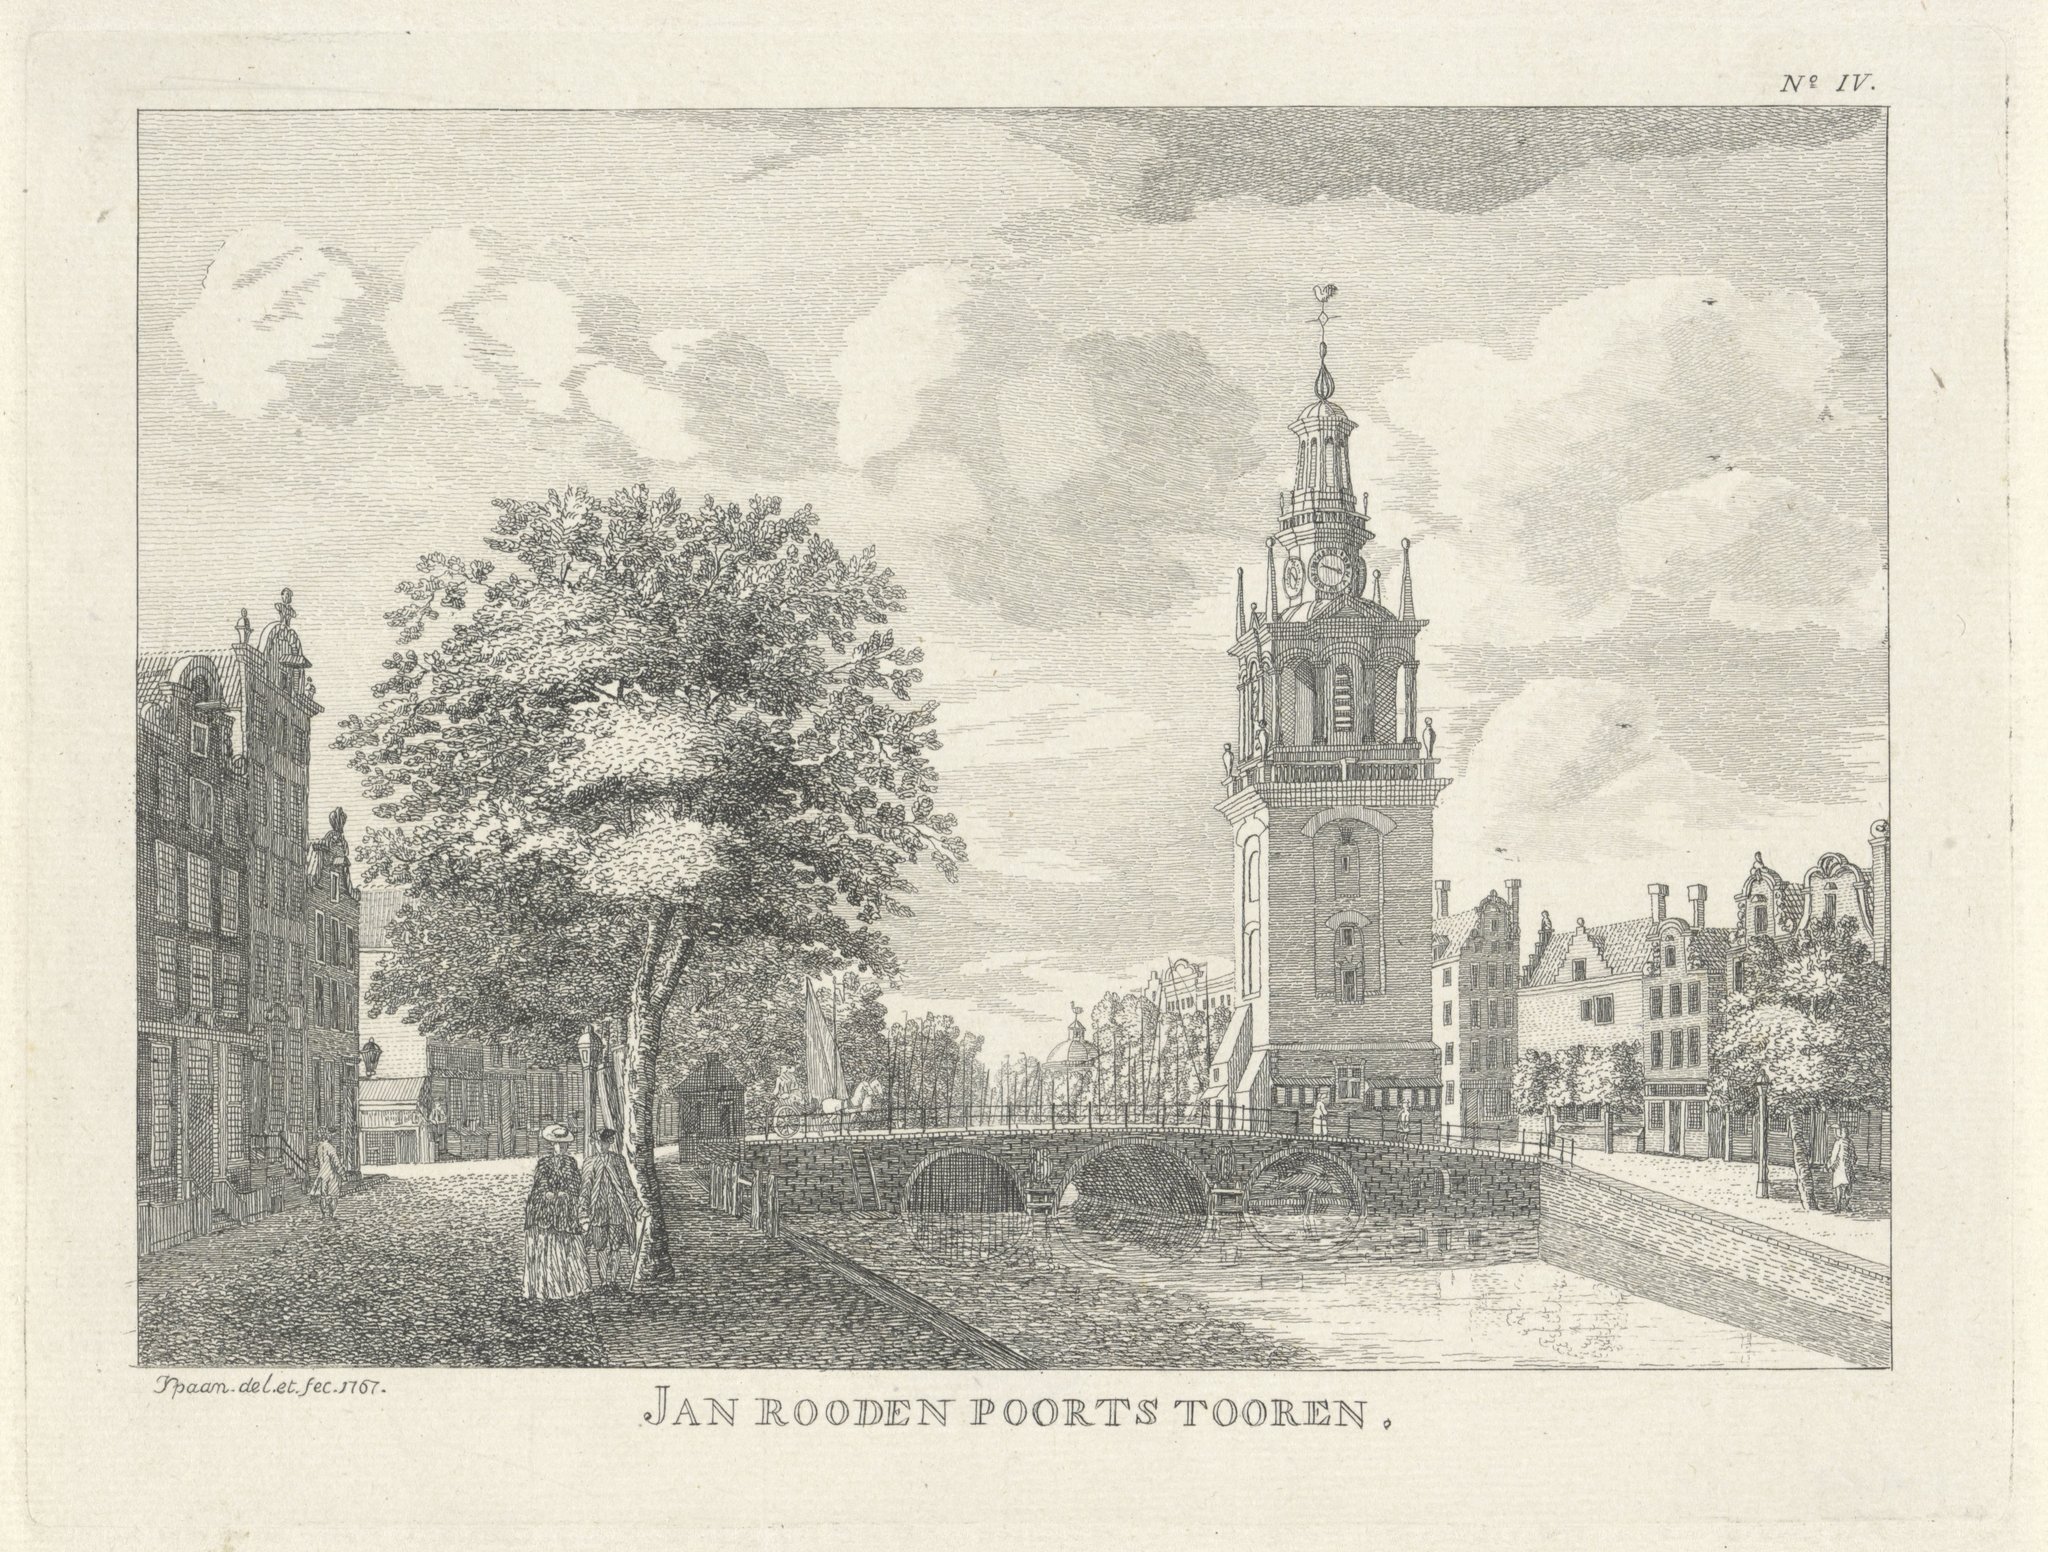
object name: print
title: Jan Rooden Poorts Tooren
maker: jan spaan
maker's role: print maker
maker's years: 1742-1828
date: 1767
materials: paper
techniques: etching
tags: amsterdam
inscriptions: collector's mark: Lugt 2228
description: Een koets rijdt over de brug bij de Jan Roodenpoortstoren te Amsterdam. Mensen wandelen langs de gracht. Genummerd "No. IV".